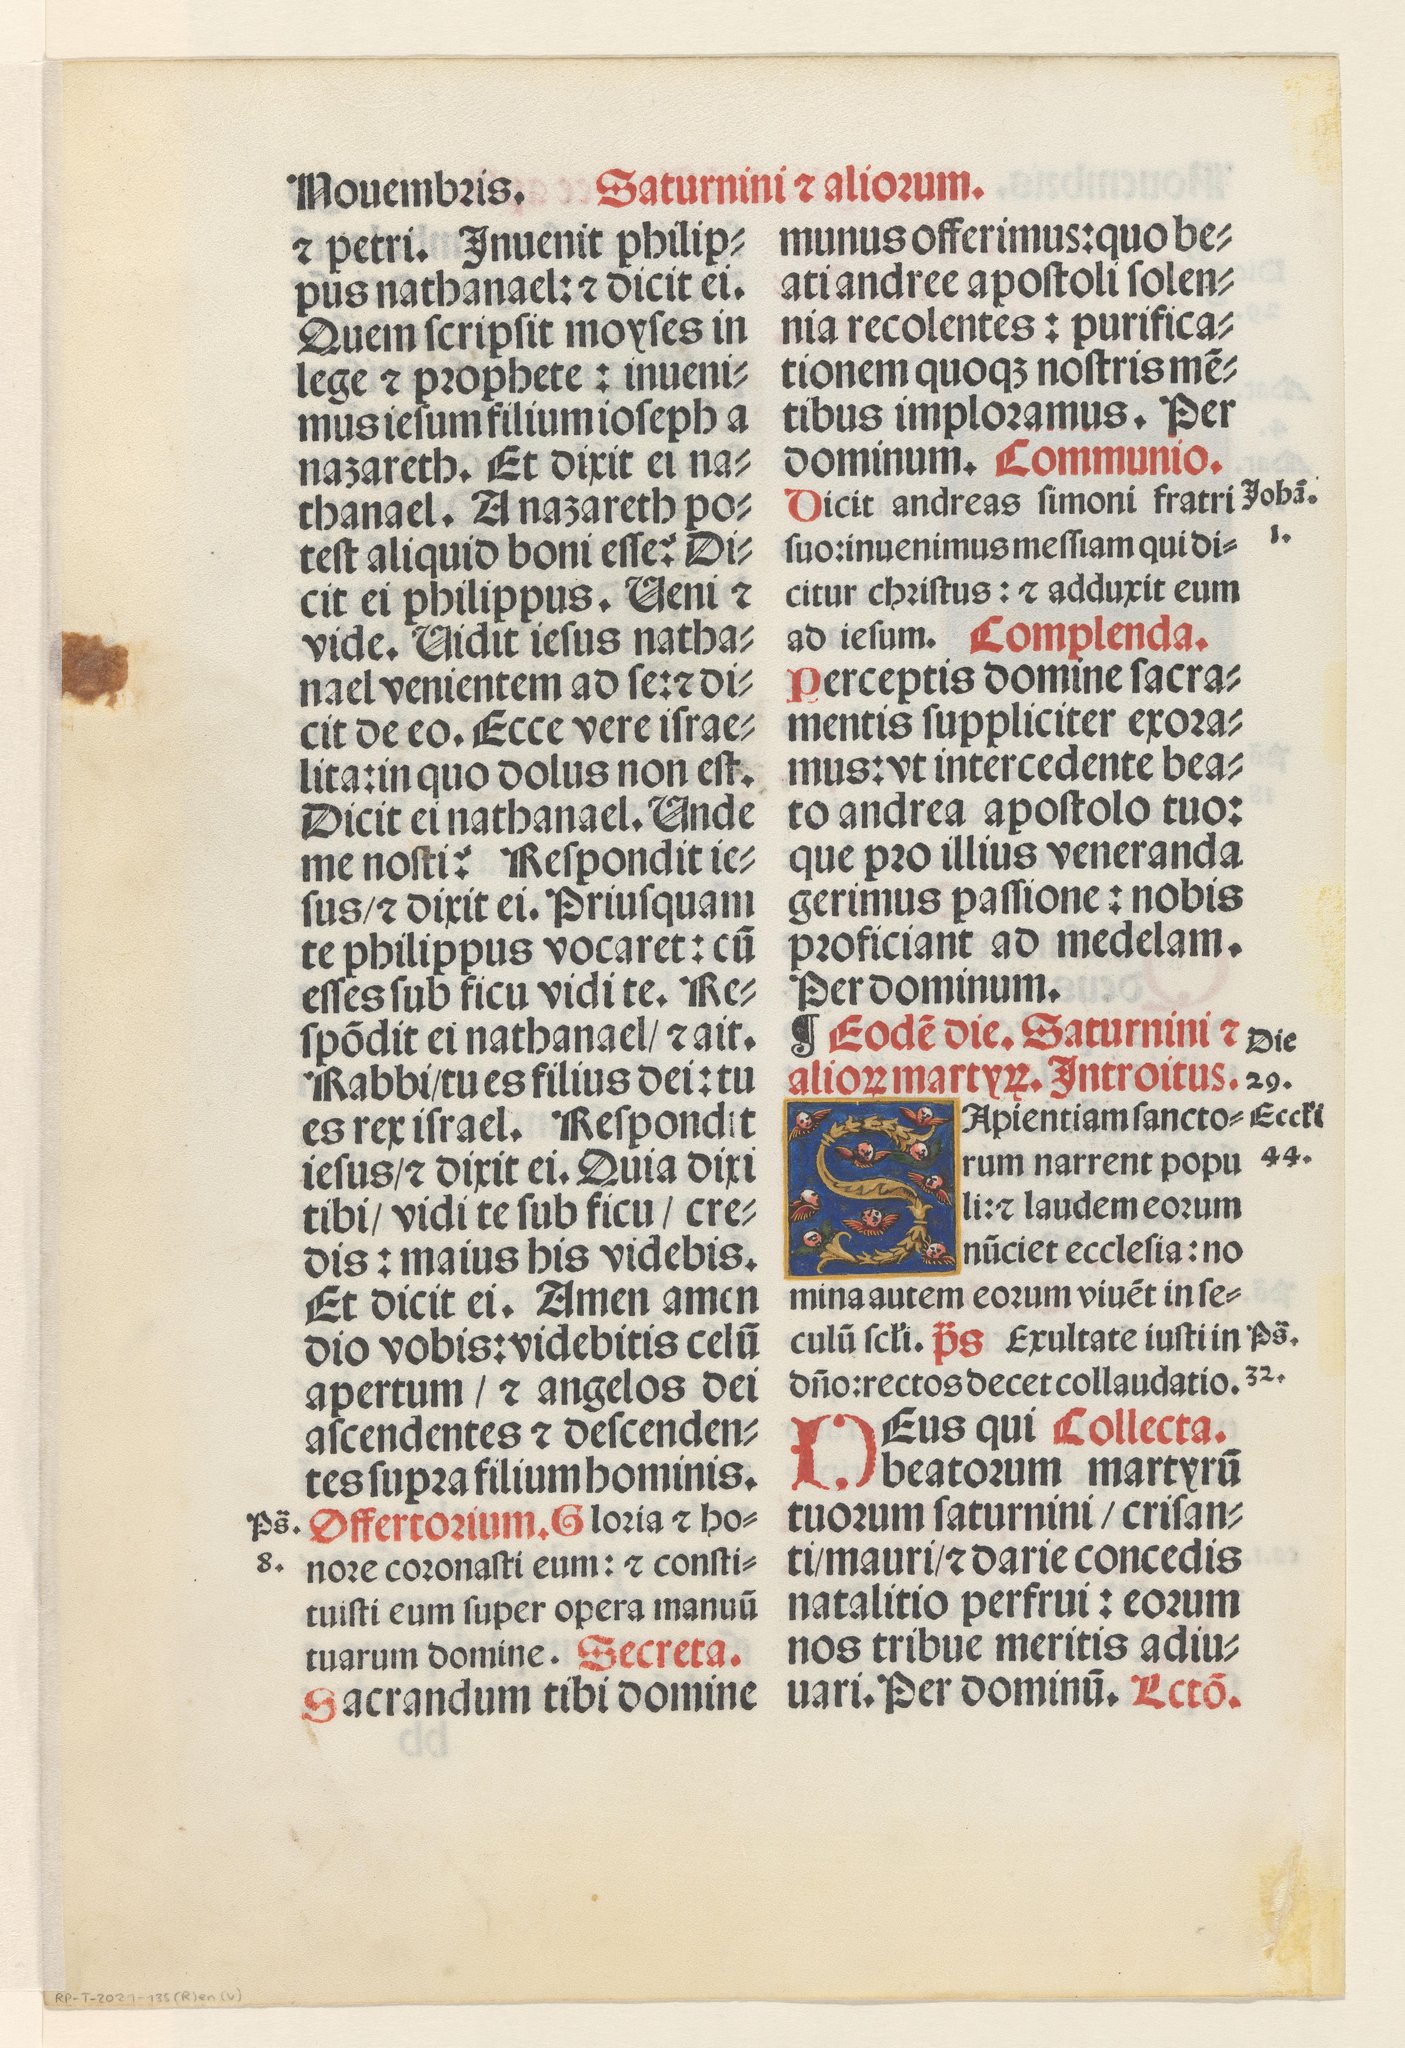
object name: page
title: Blad uit een getijdenboek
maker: Anonymous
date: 1450-1499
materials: paint, ink, paper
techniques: brush, letterpress printing, pen